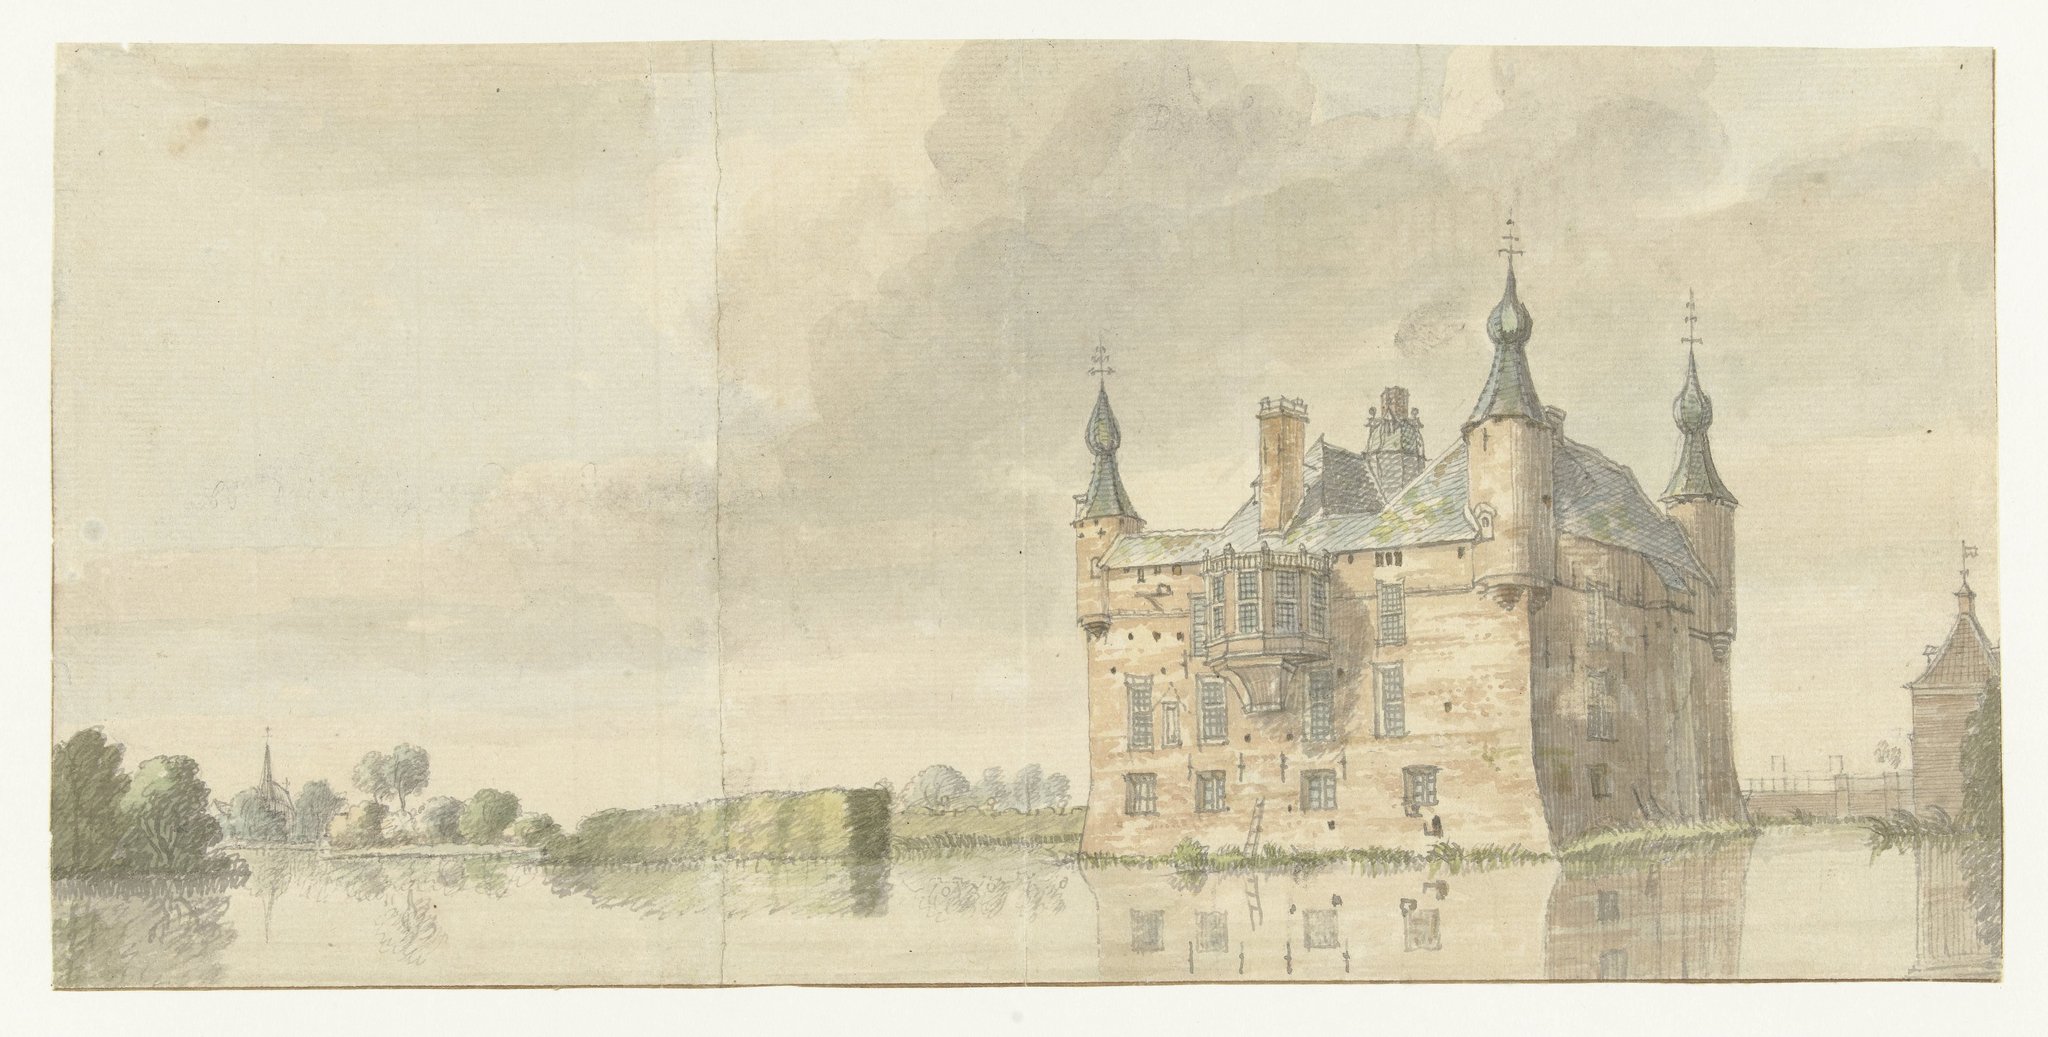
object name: watercolor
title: Het Huis Driesberg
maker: jan de beijer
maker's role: draughtsman, print maker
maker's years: 1703-1780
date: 1744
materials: ink, paper, watercolor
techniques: brush, pen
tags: castle